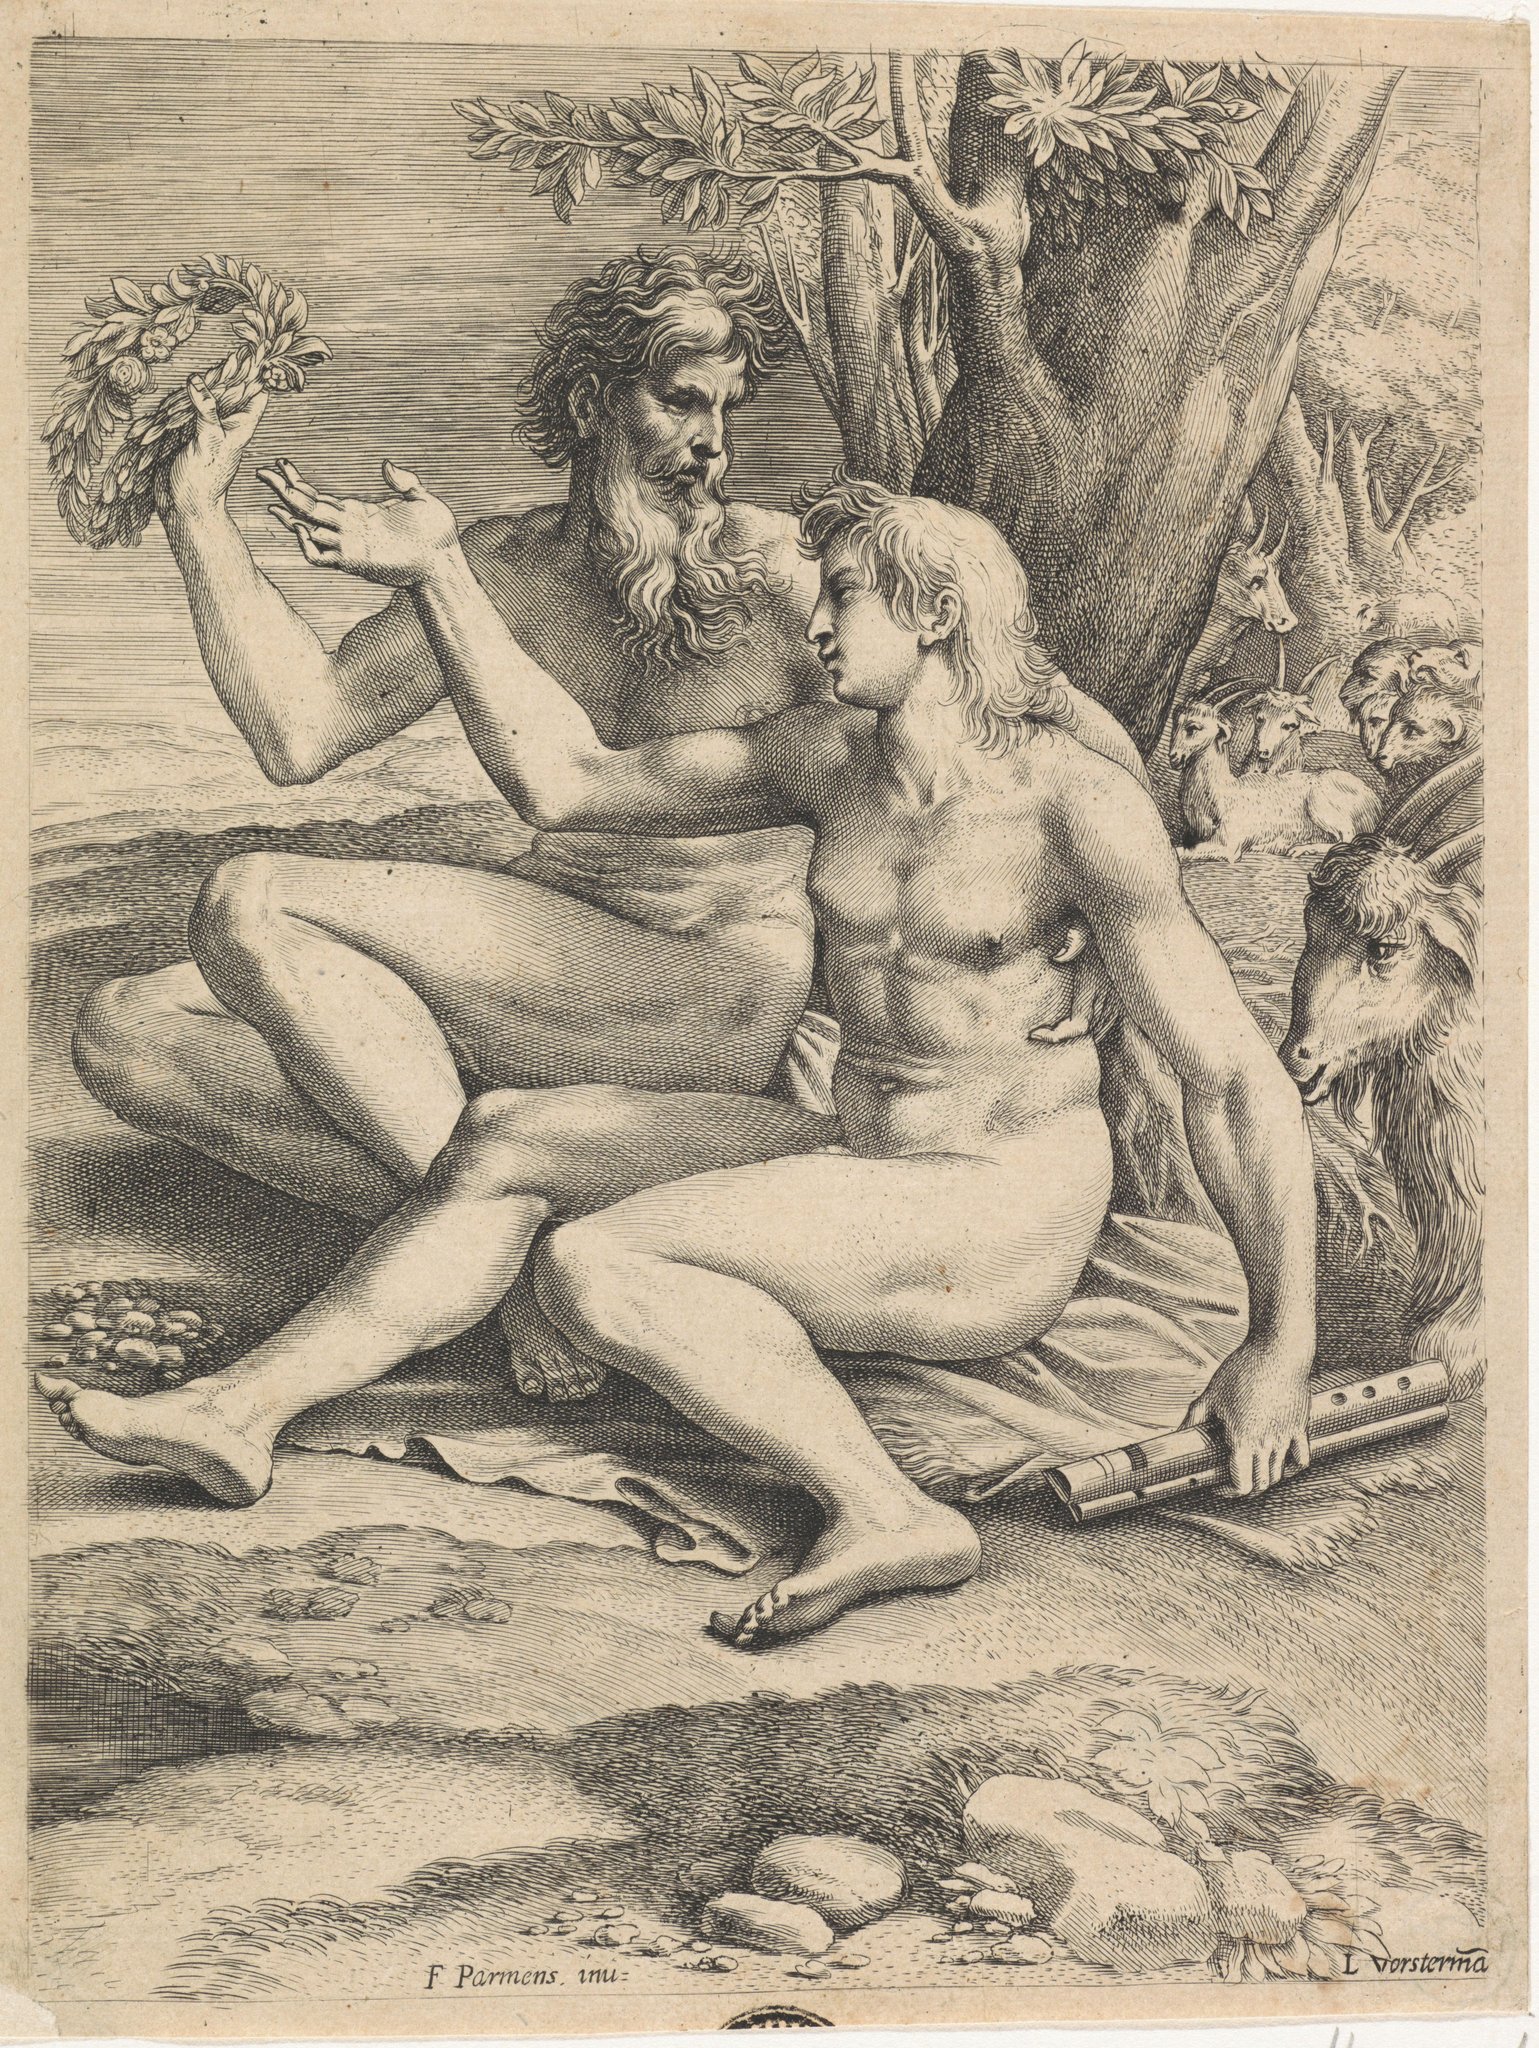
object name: print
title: Jonge en een oude geitenhoeder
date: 1619-1675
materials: paper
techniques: engraving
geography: antwerp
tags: herding, herdsman, herdswoman, shepherd, shepherdess, cowherd, etc., goat, flute, aulos, tibia - cc - out of doors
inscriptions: collector's mark: Lugt 2228, collector's mark: Lugt 548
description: Twee naakte geitenhoeders. De oudere heeft een krans vast en een arm om de jonge geitenhoeder geslagen. Deze heft zijn hand op naar de krans en houdt in de ander hand een fluit.